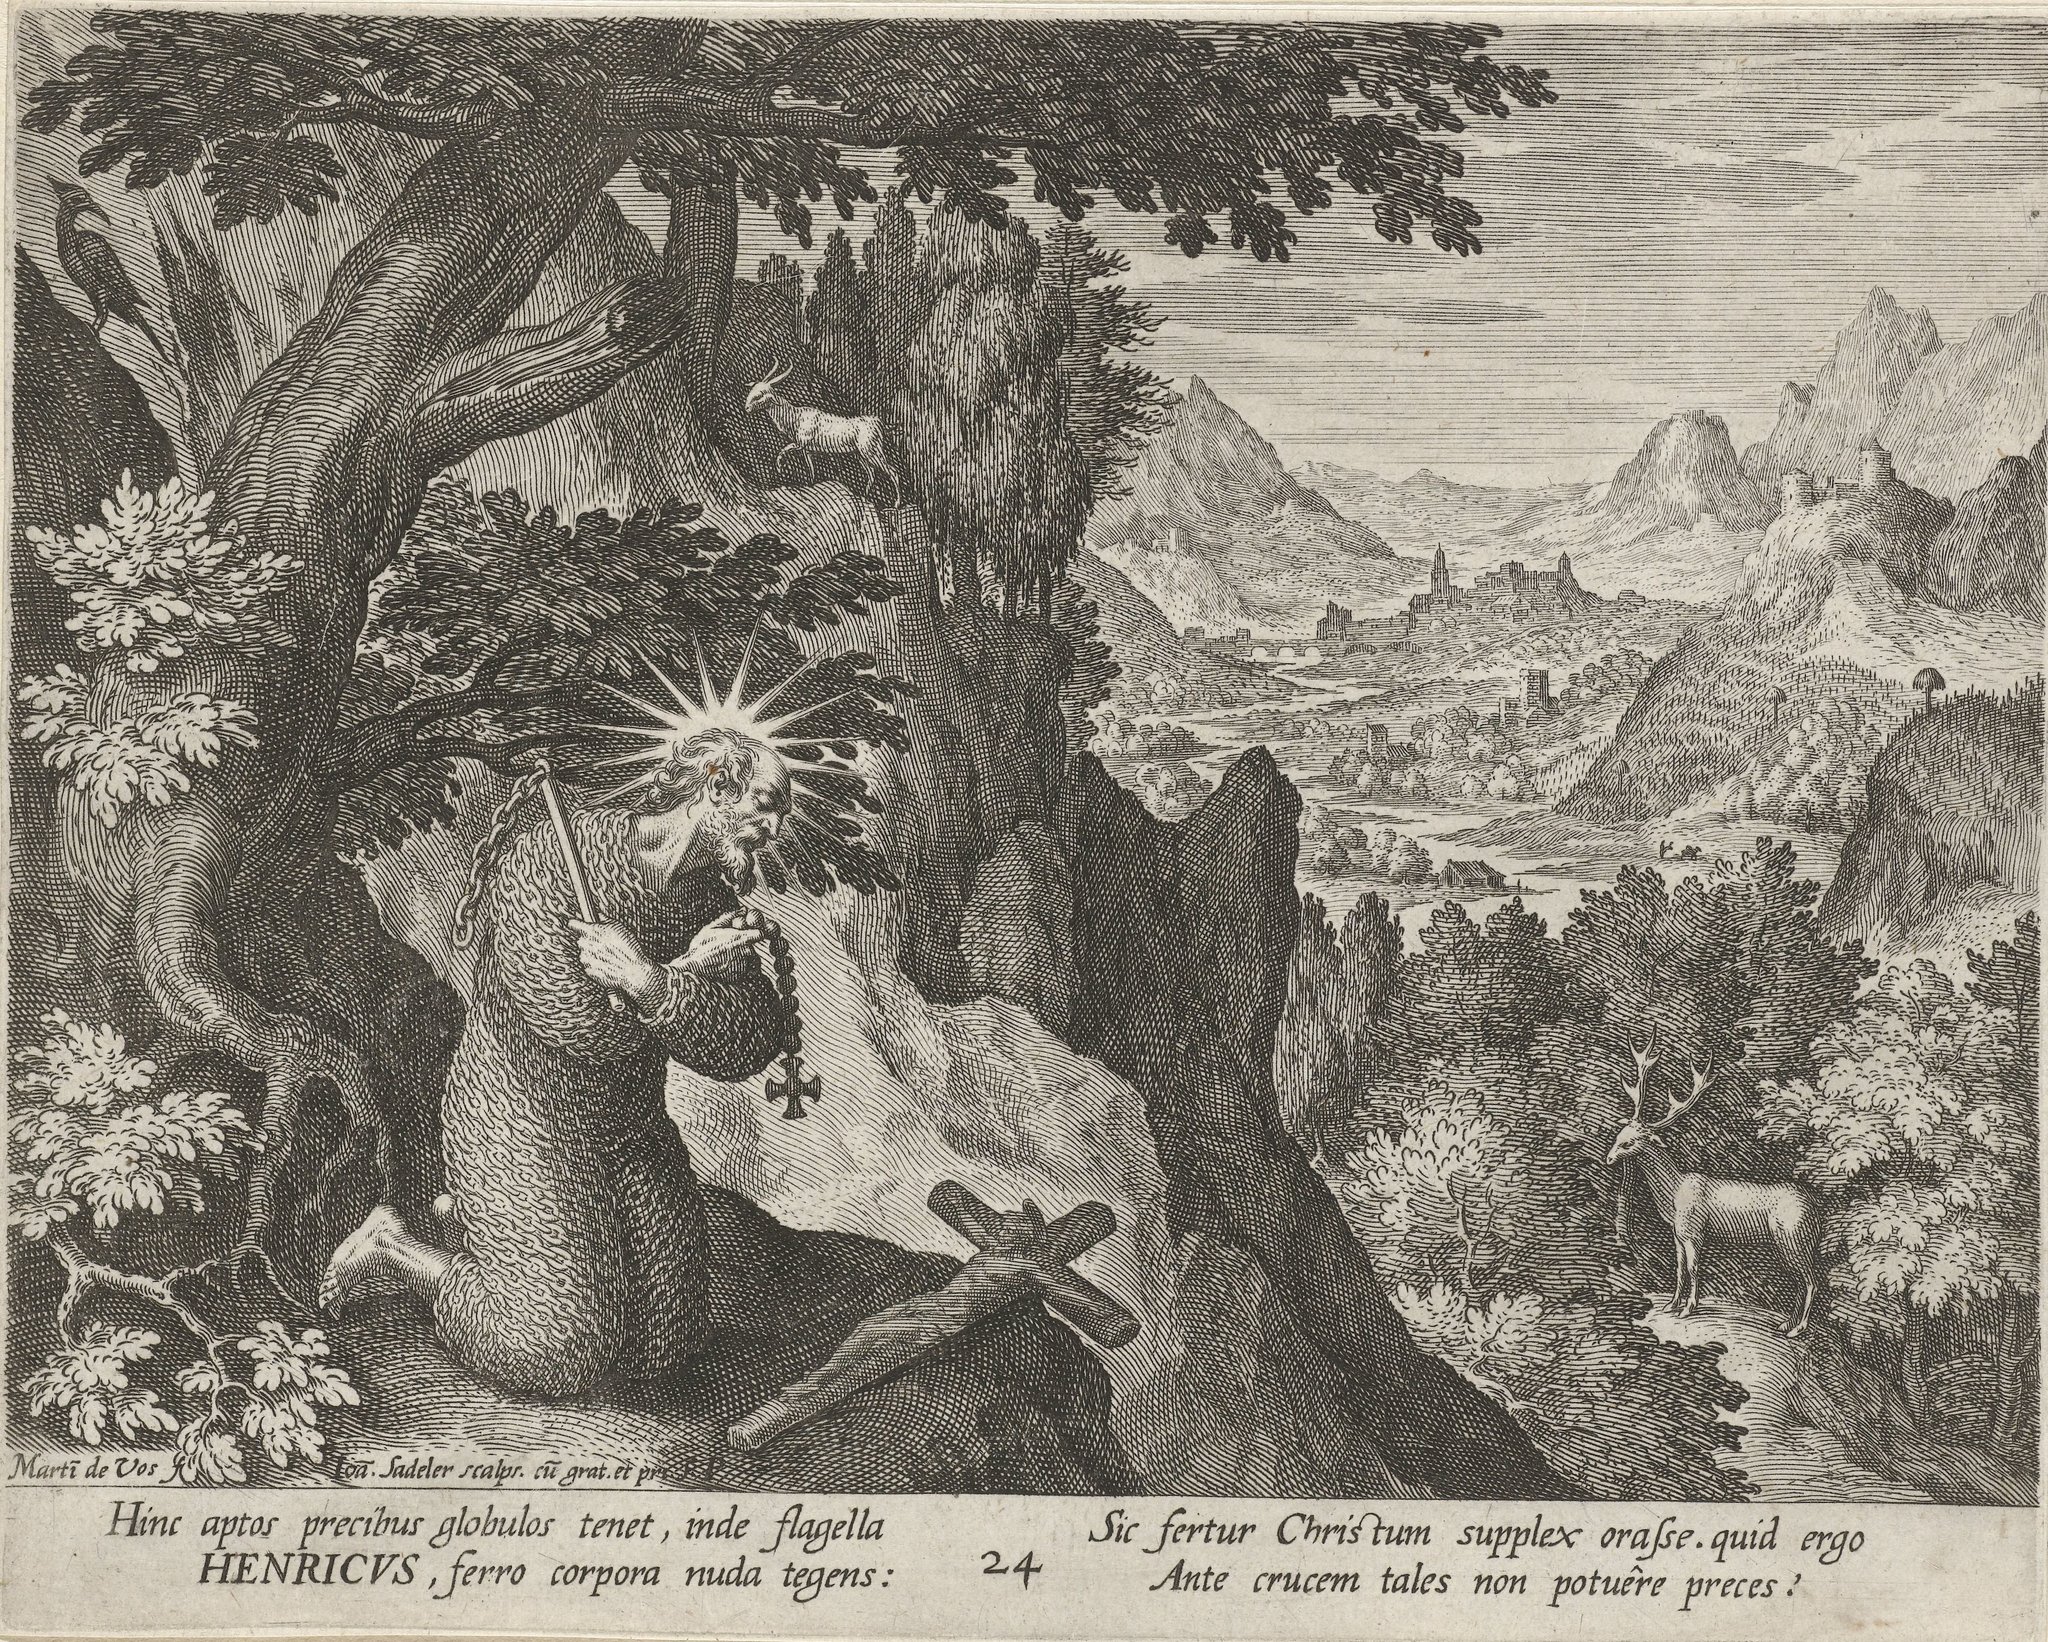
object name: print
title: Het deugdzame leven van kluizenaars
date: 1598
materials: paper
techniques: engraving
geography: venice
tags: male saints (with name), hoofed animals: deer, altarcross, crucifix, self-castigation ~ ascetic life, anchorite, hermit, tools, aids, implements ~ crafts and industries: chain, mountains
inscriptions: collector's mark: Lugt 240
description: Op de voorgrond de H. Hendrik van Cocket, een Deense kluizenaar uit de twaalfde eeuw na Christus. Hij zit geknield te bidden voor een crucifix en slaat zichzelf met een ijzeren gesel. Zijn lichaam is in kettingen gewikkeld. Op de achtergrond een berglandschap met een hert.